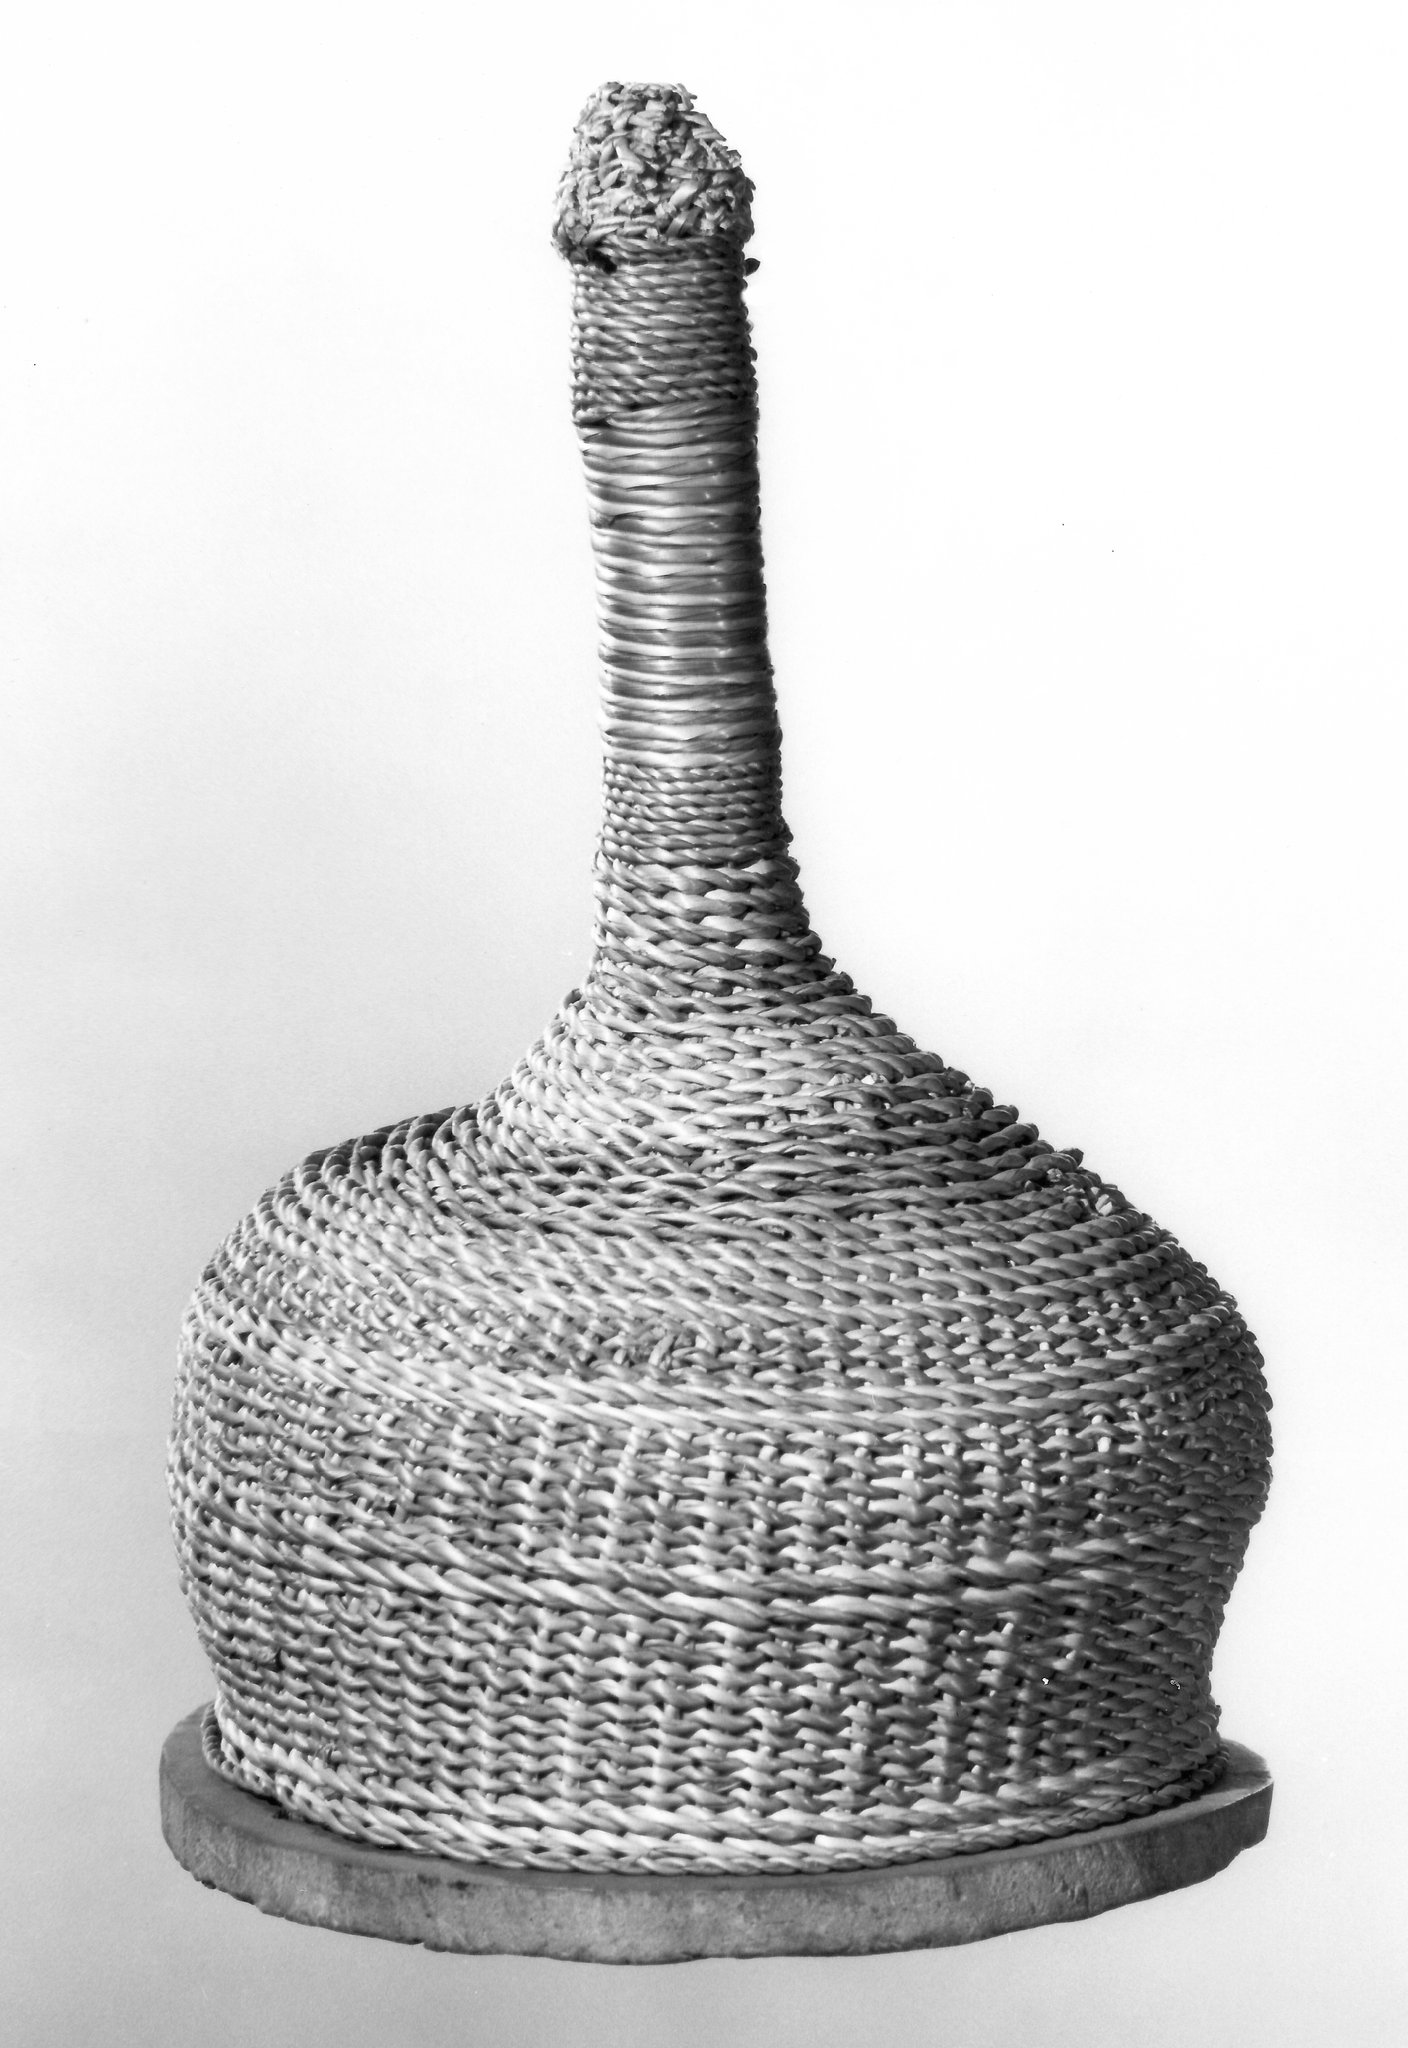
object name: rattle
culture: west african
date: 1867-1900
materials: skin